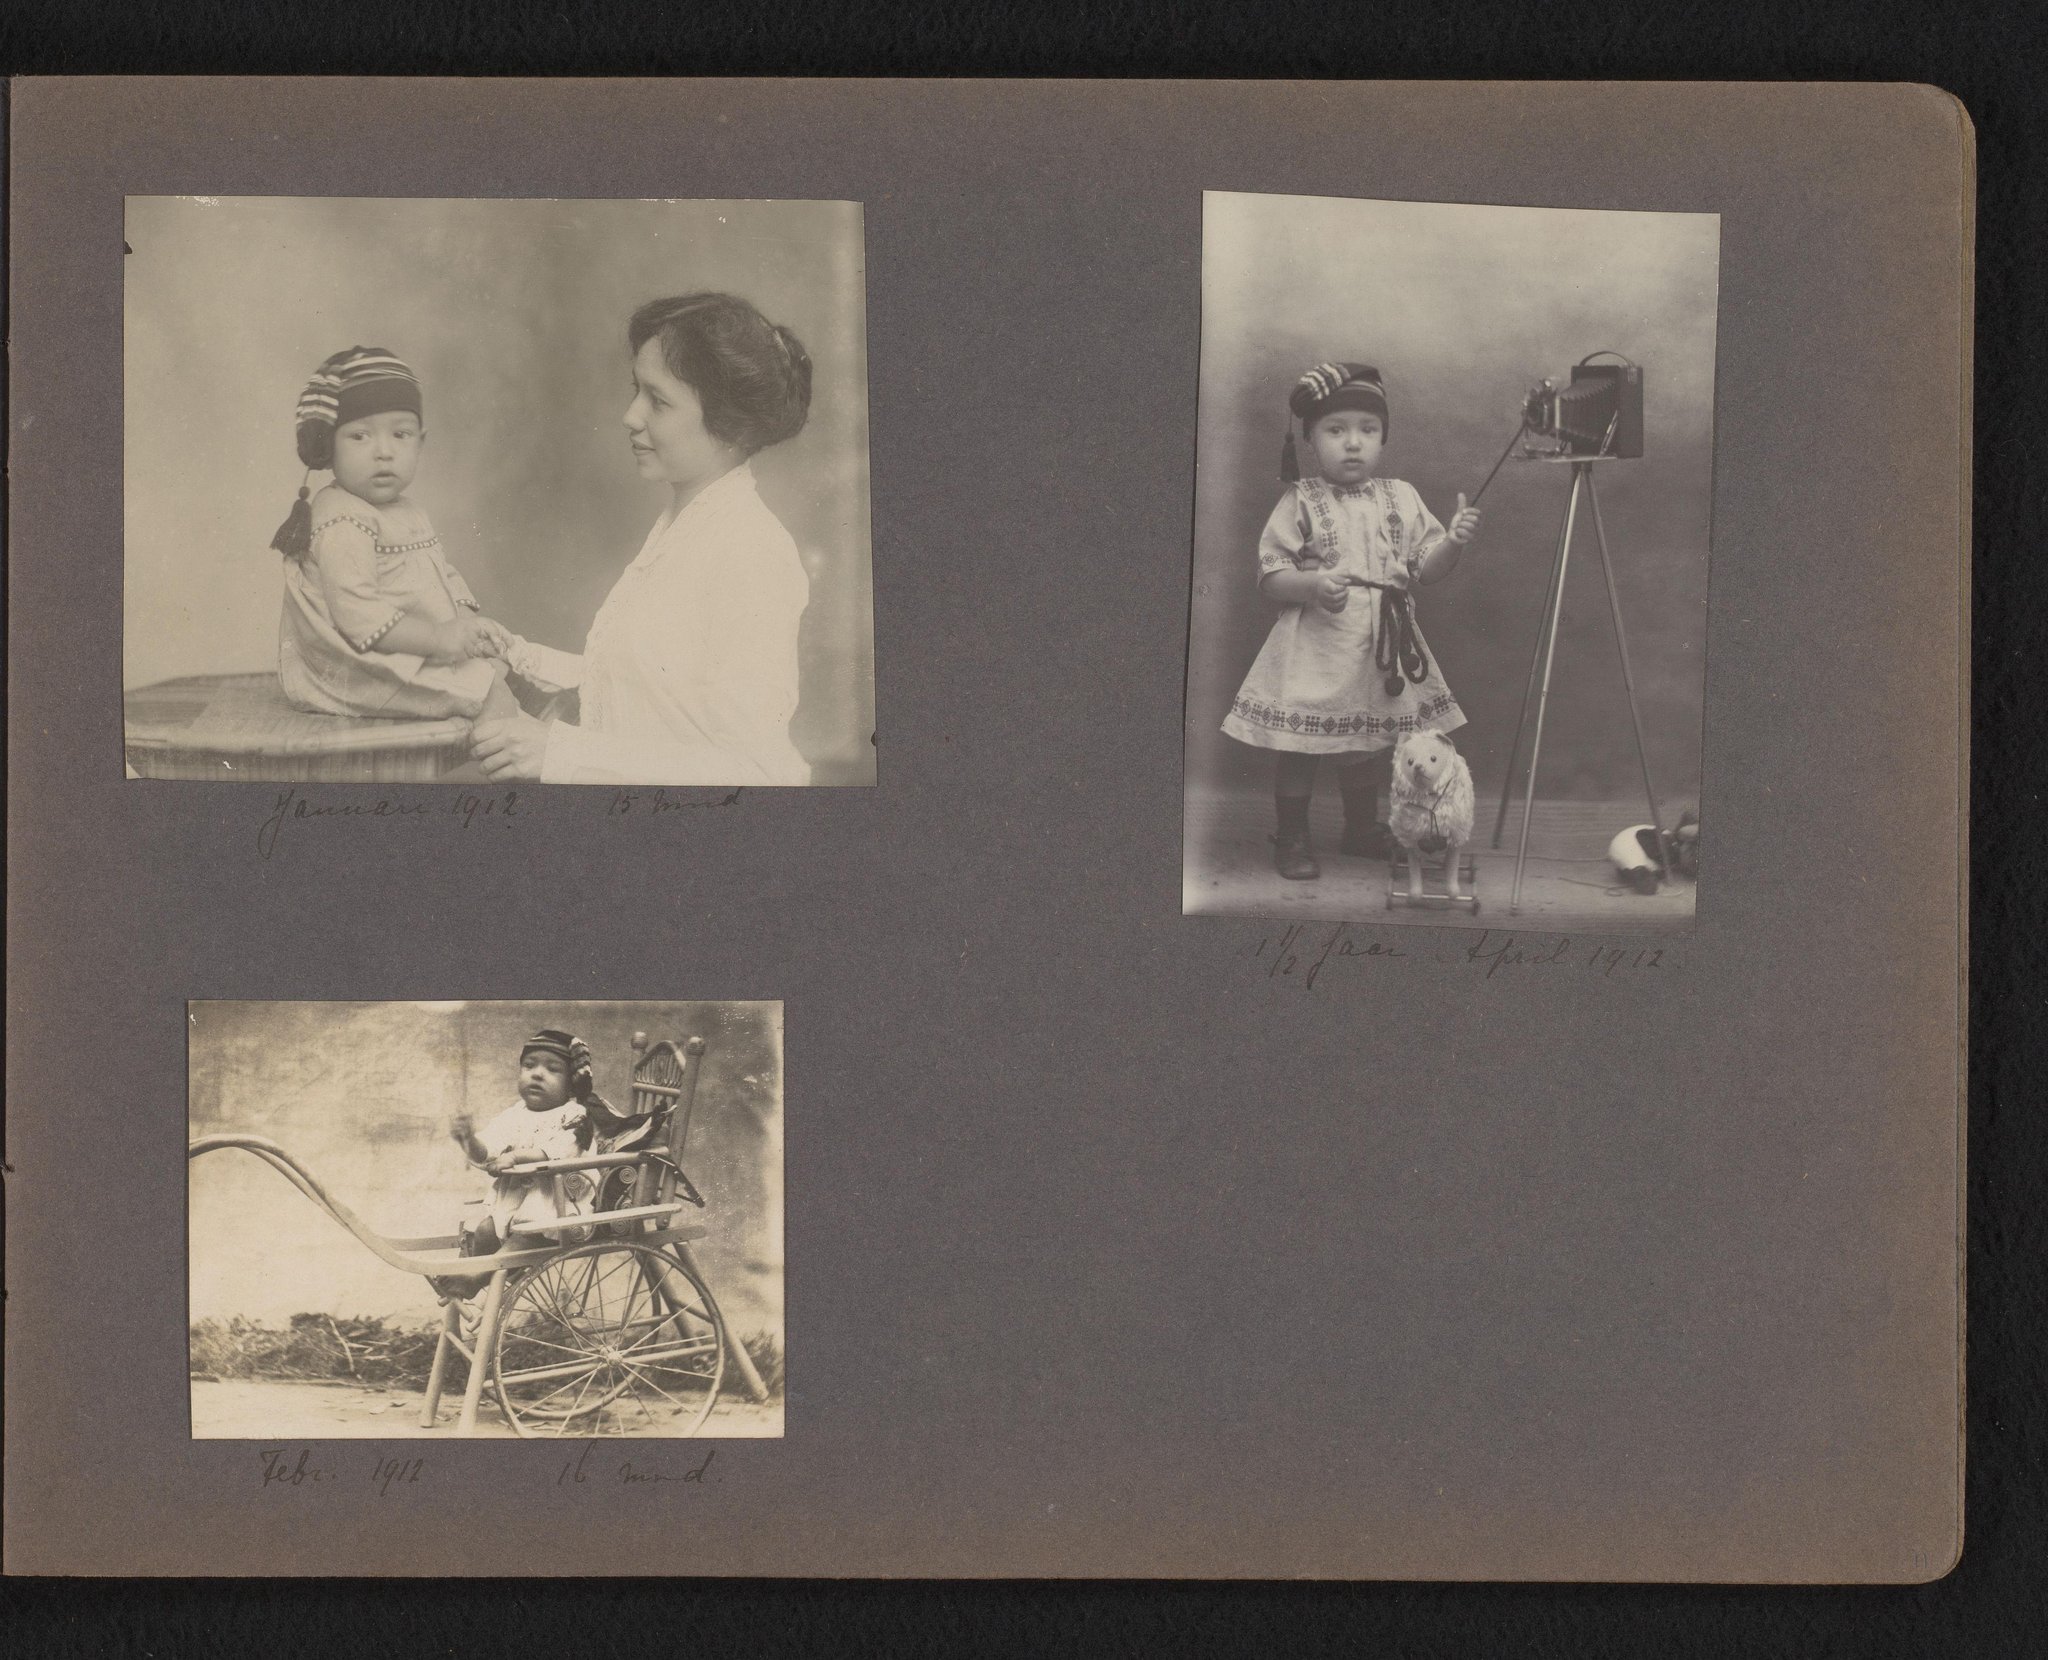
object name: album leaf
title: Drie foto's van Han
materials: cardboard, photographic support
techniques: gelatin silver print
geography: dutch east indies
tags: java, baby-carriage, pram, perambulator, camera ~ photography, male infant, family life at home, dutch east indies, the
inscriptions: annotation: ‘Januari 1912. 15 mnd / Febr. 1912 16 mnd. / 1½ Jaar. April 1912.’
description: Blad met drie foto's van baby Han Dumas in een fotostudio met zijn moeder en verkleed poserend met een fototoestel en buiten in een kinderwagen. Onderdeel van het fotoalbum over de kindertijd van Han (geboren sept-okt 1910) en Eef Dumas (geboren februari 1915) in Nederlands-Indië.